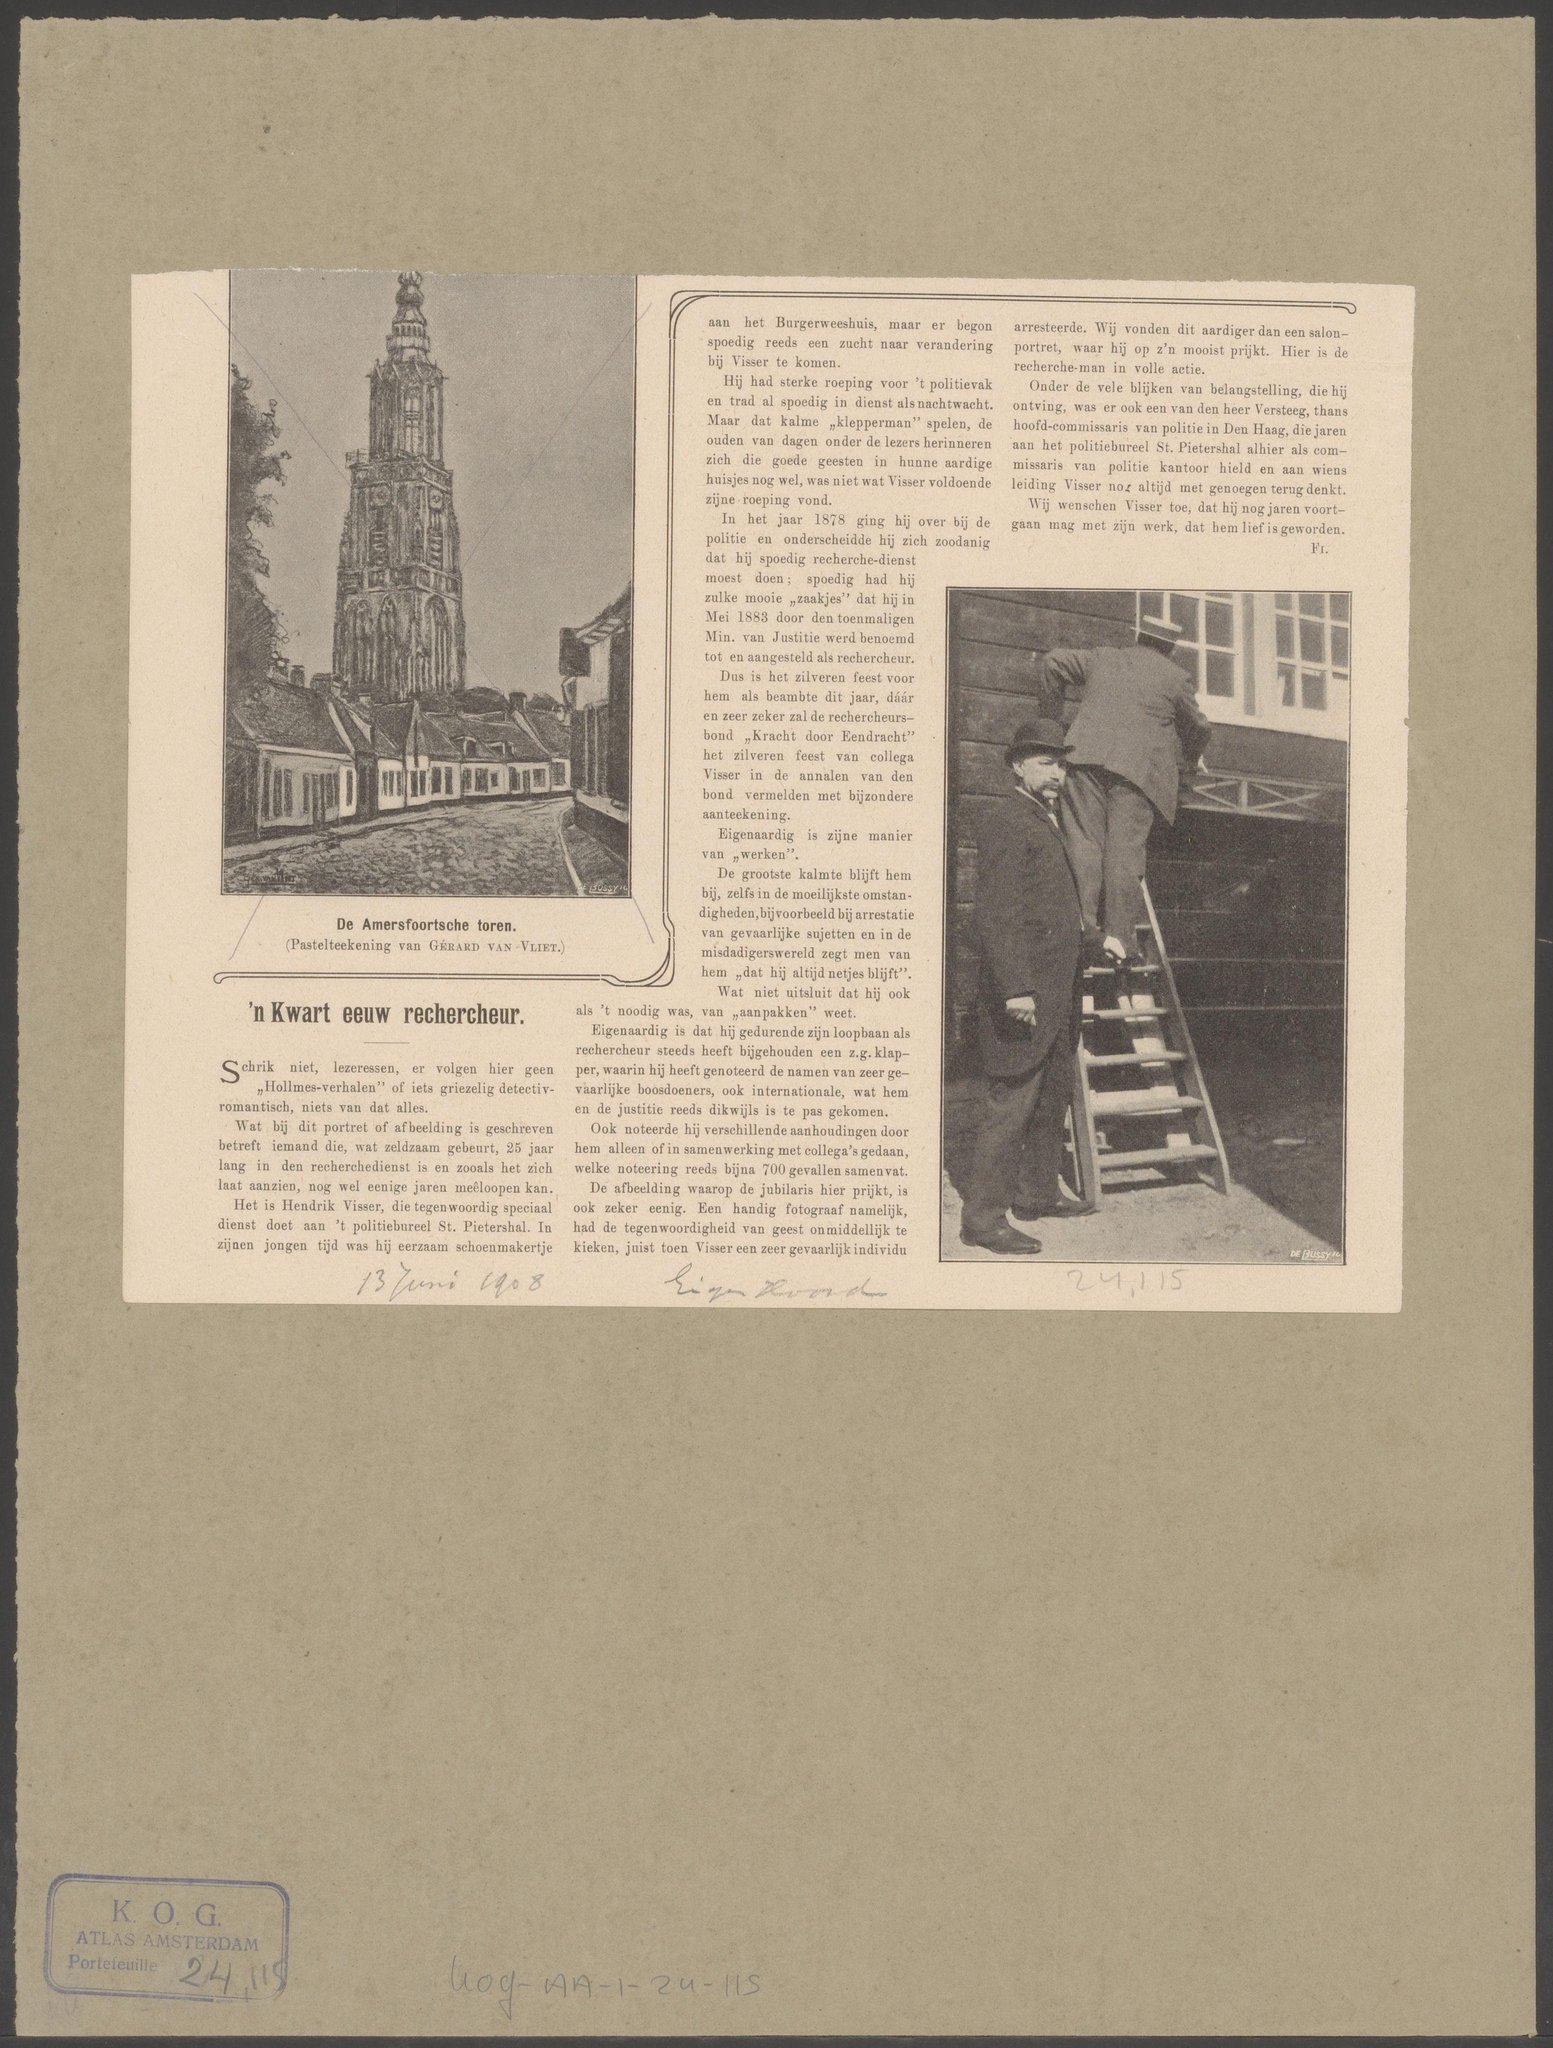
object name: photomechanical print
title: 'n Kwart eeuw rechercheur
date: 1908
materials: paper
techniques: letterpress printing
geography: amsterdam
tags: historical persons, arrest (of criminal), amsterdam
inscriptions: collector's mark: Lugt 1641b, signature: ‘Fr.’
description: Prent uit: Van Week tot Week (1908), 13 juni 1908, p. 4.